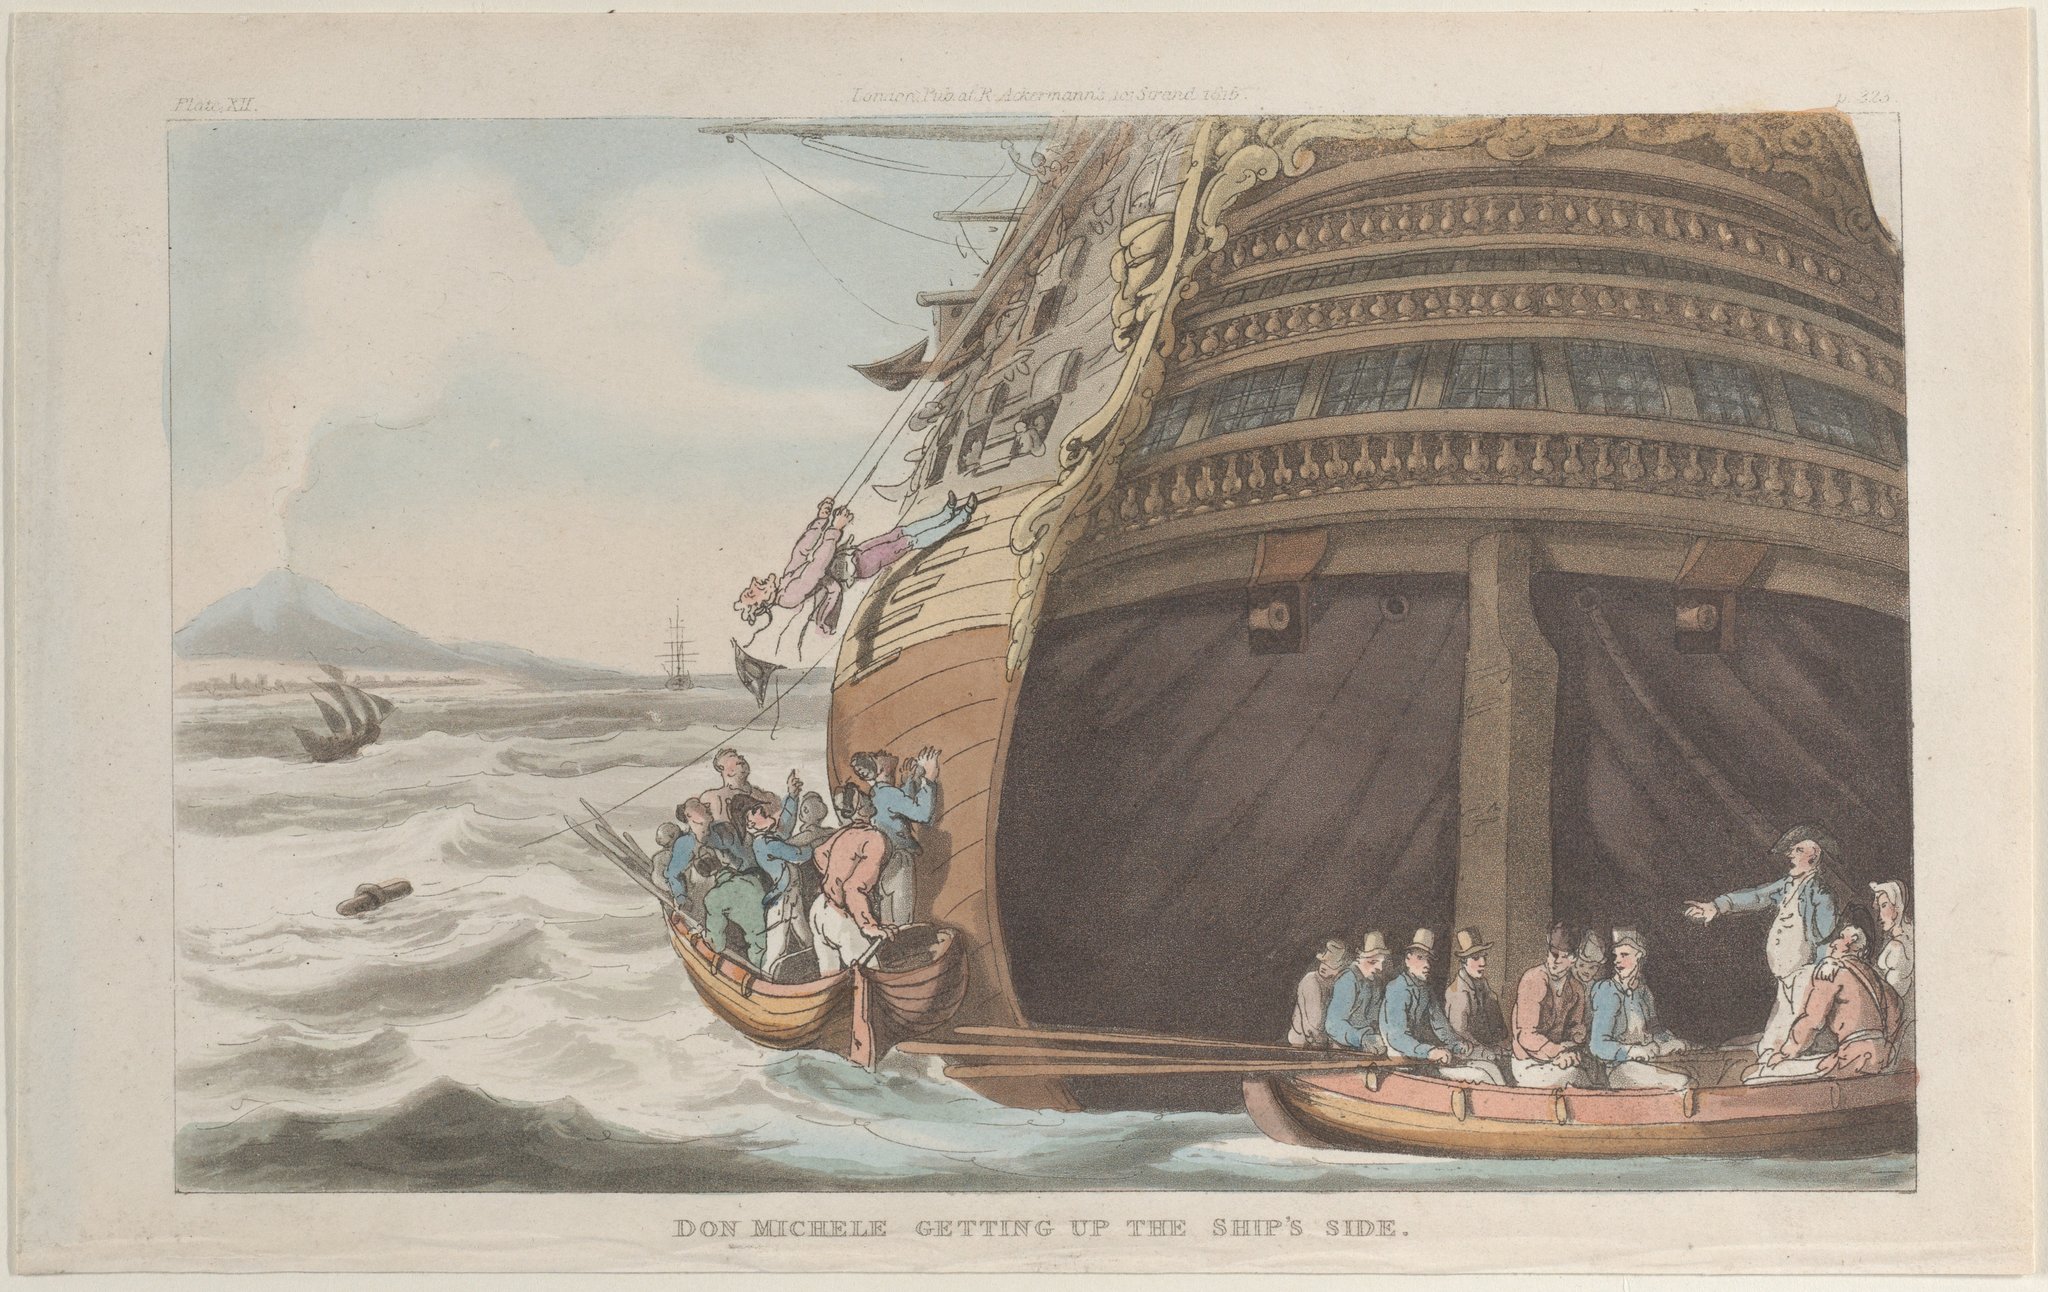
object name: print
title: Don Michele Getting Up the Ship's Side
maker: thomas rowlandson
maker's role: artist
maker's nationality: british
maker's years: 1757-1827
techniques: aquatint, etching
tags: men,boats,ships